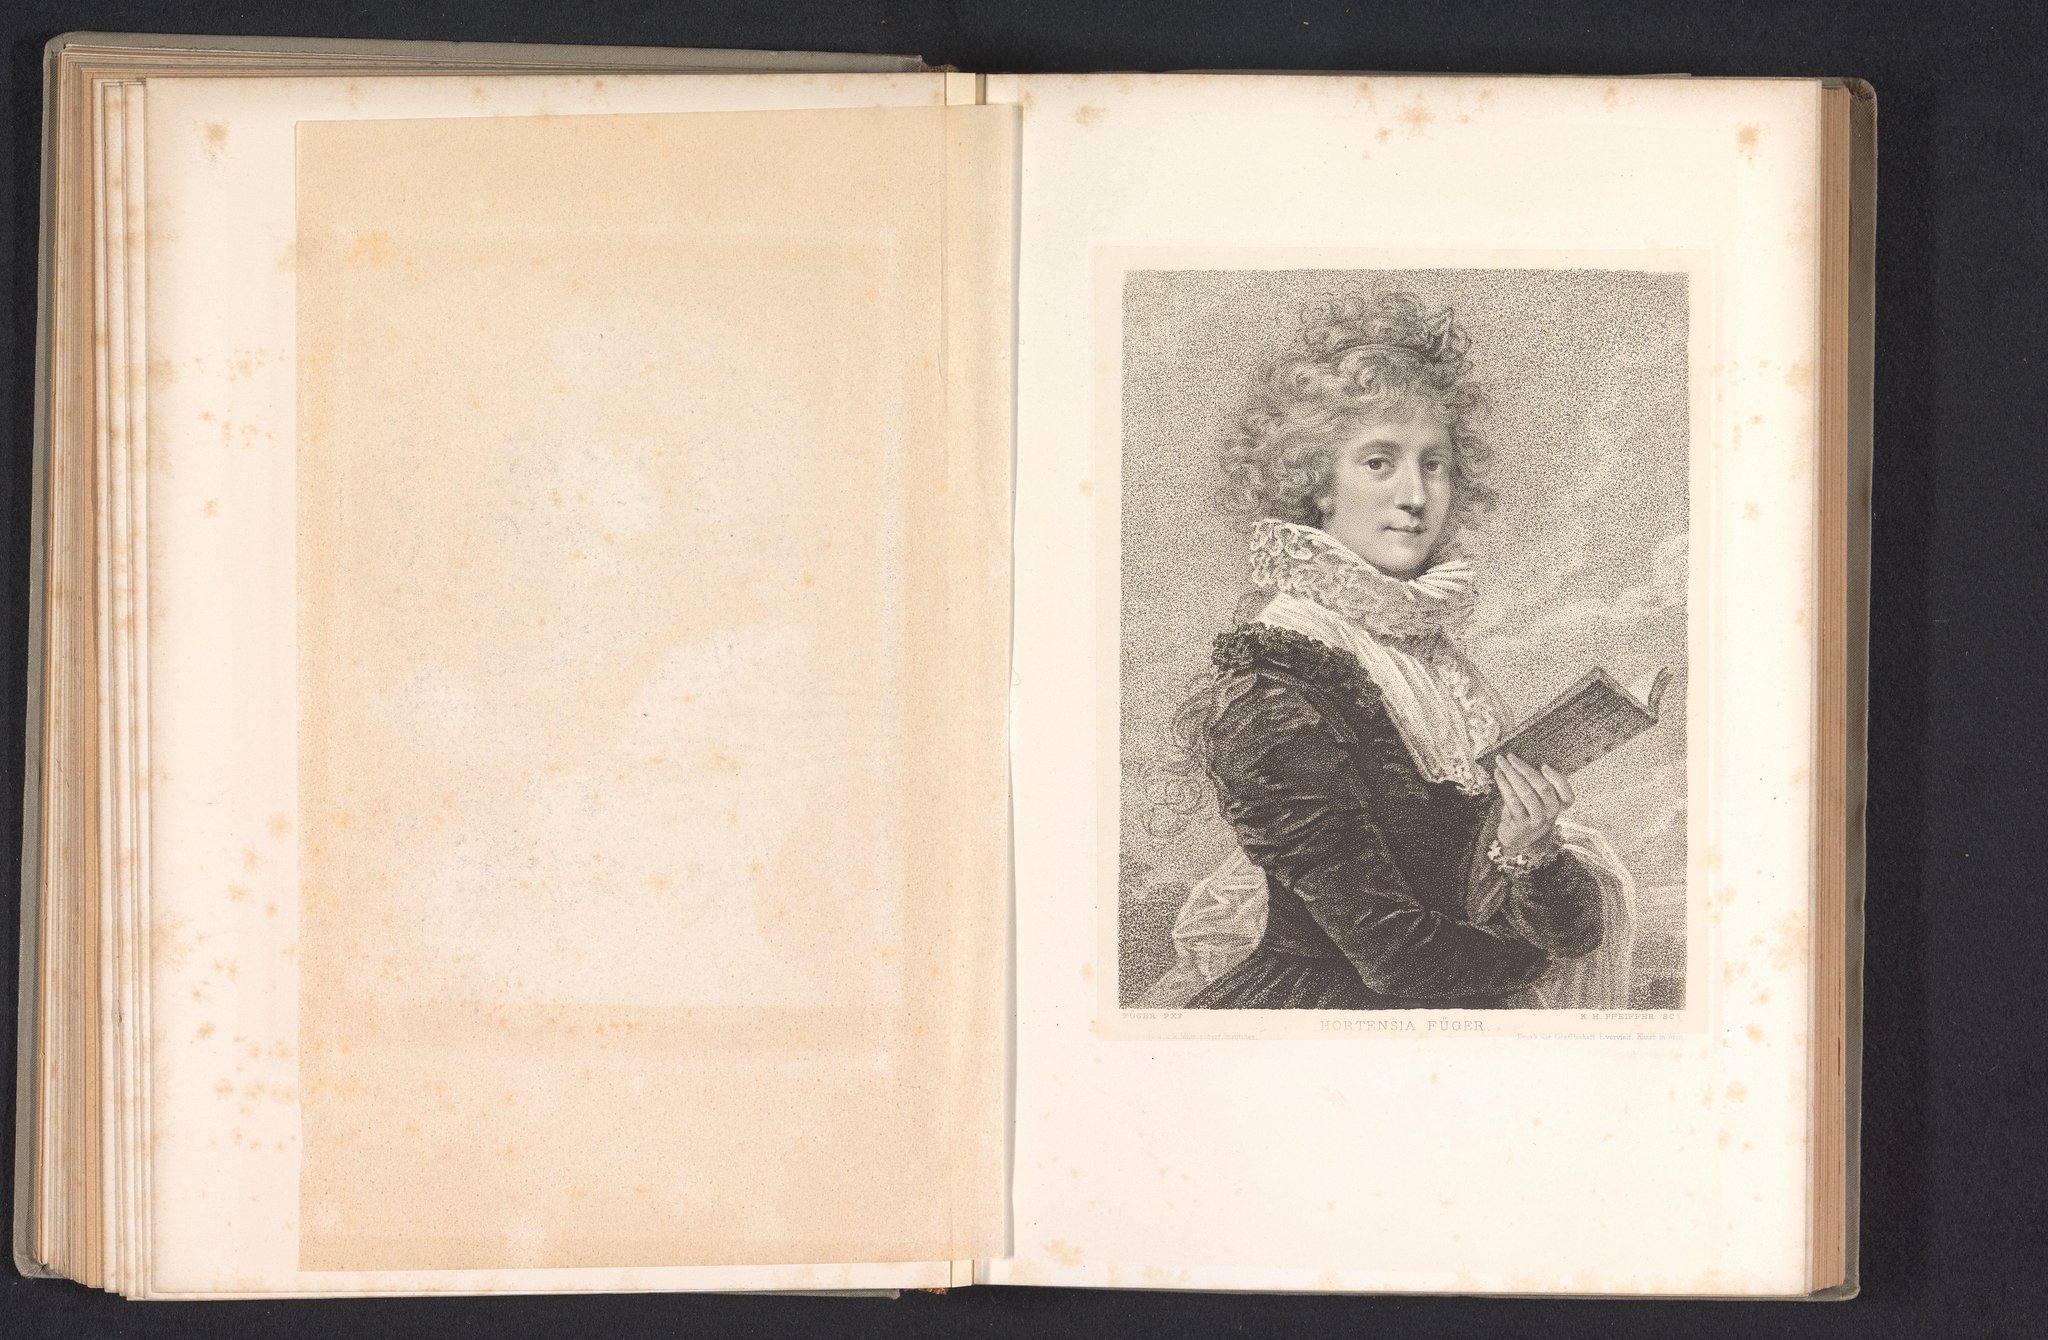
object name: reproduction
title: Hortensia Füger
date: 1878-1883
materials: paper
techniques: photoaquatint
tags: portrait of actor, actress